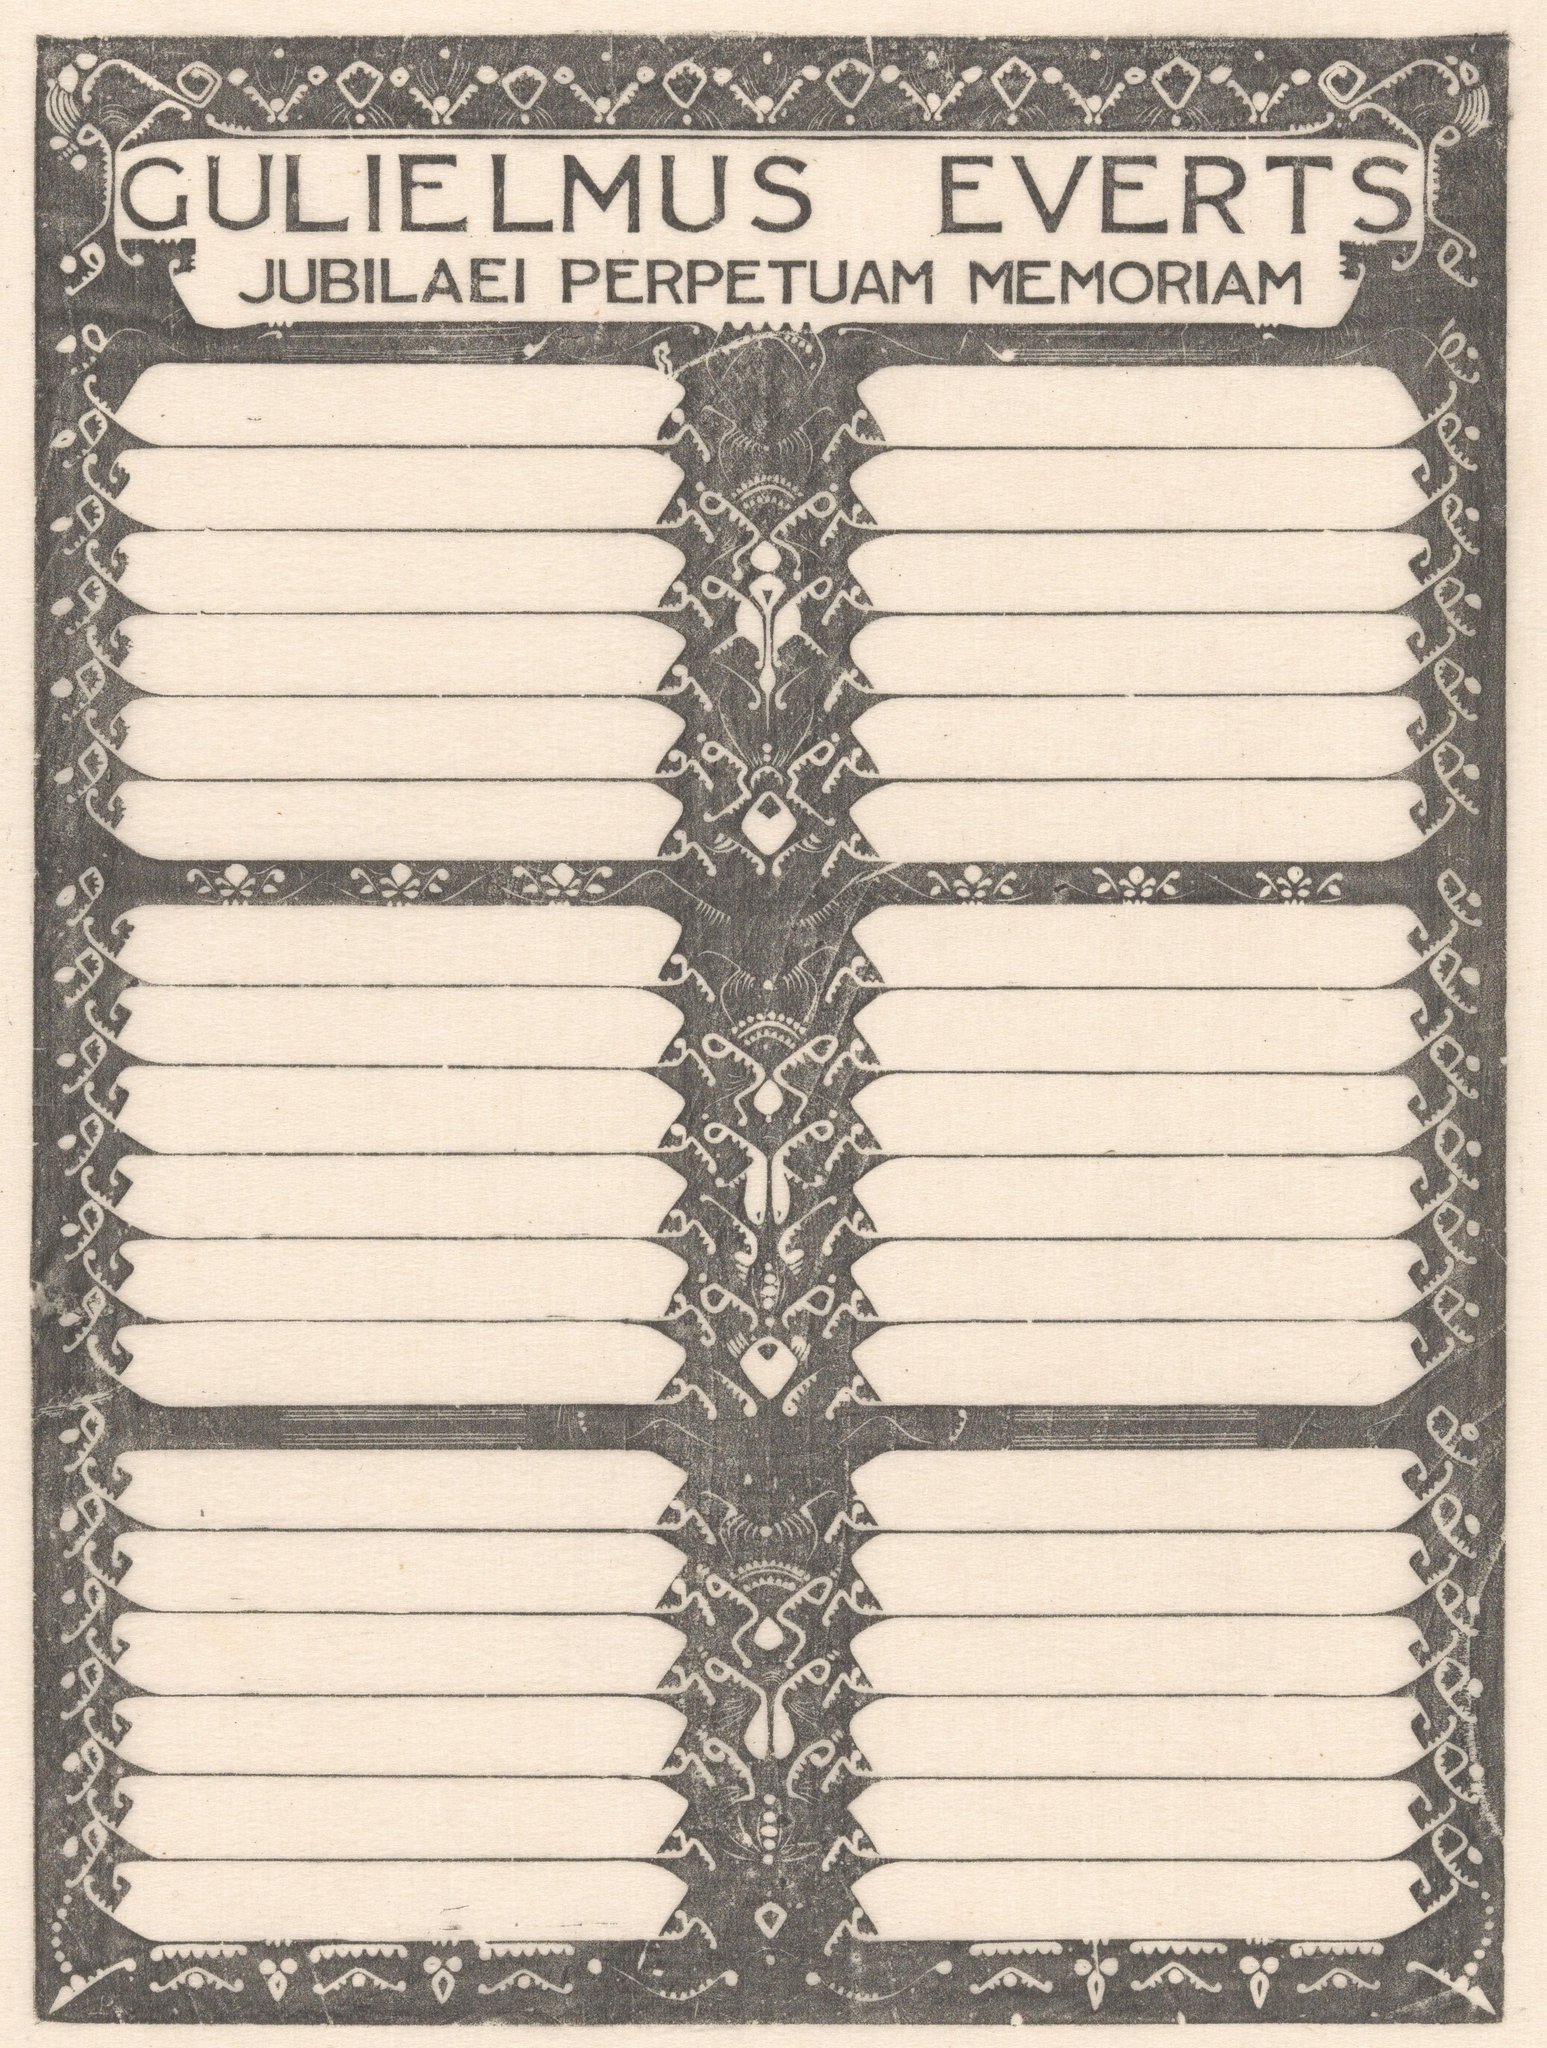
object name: print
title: Oorkonde voor Gulielmus Everts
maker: karel petrus cornelis de bazel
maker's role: draughtsman, print maker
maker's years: 1869-1923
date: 1897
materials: paper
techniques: woodcut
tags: politician, commemoration, jubilee, printed matter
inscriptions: collector's mark: Lugt 2228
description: Met de gedrukte tekst 'jubilaei perpetuam memoriam'.